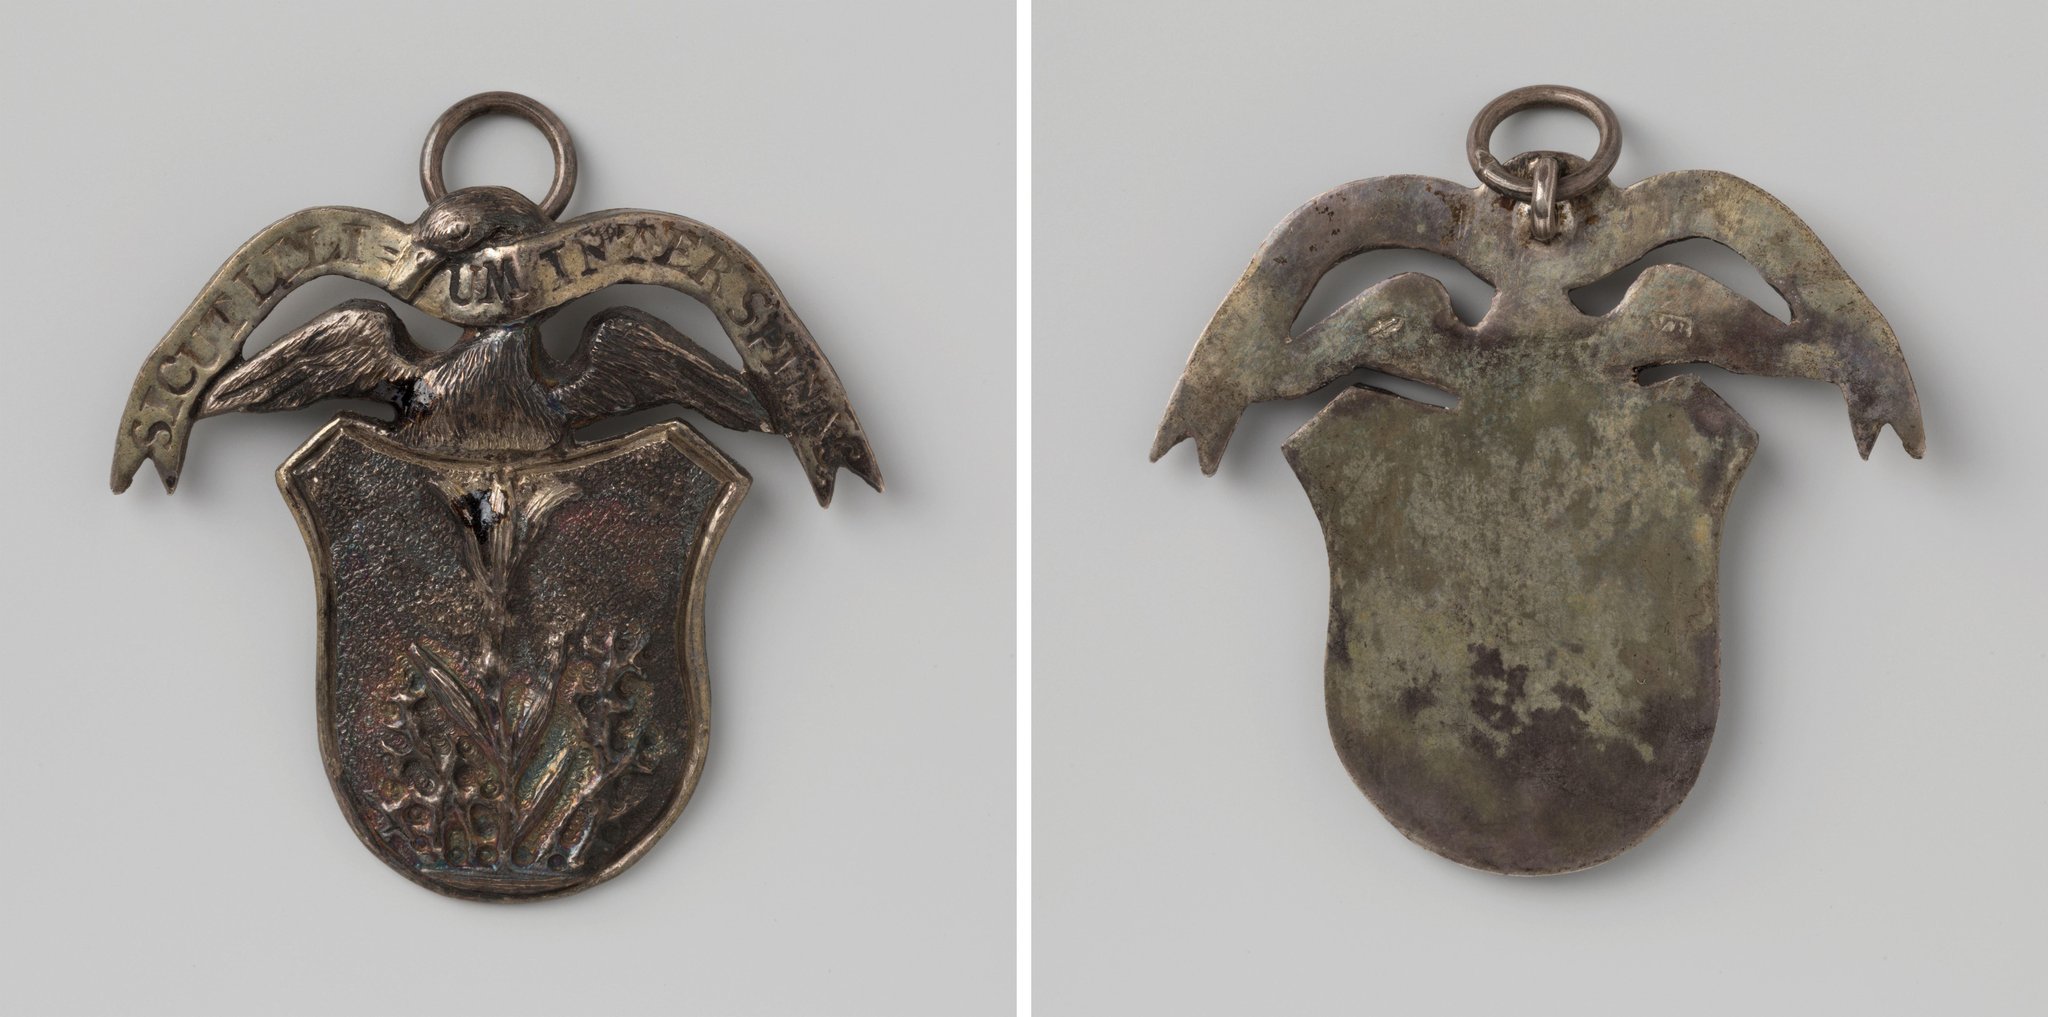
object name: history medal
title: Draagteken van de Illustere Lieve Vrouwen Broederschap te 's Hertogenbosch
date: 1700-1800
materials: silver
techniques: pressing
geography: den bosch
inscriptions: maker's mark: ‘VR in rechthoek (VB ??)’, hallmark: ‘zwaard’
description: Zilveren draagteken, voorstellend een wapenschild met een lelie tussen doornen, waarboven een zwaan uitsteekt met in de snavel een lint met opschrift SICUT LILIUM INTER SPINAS